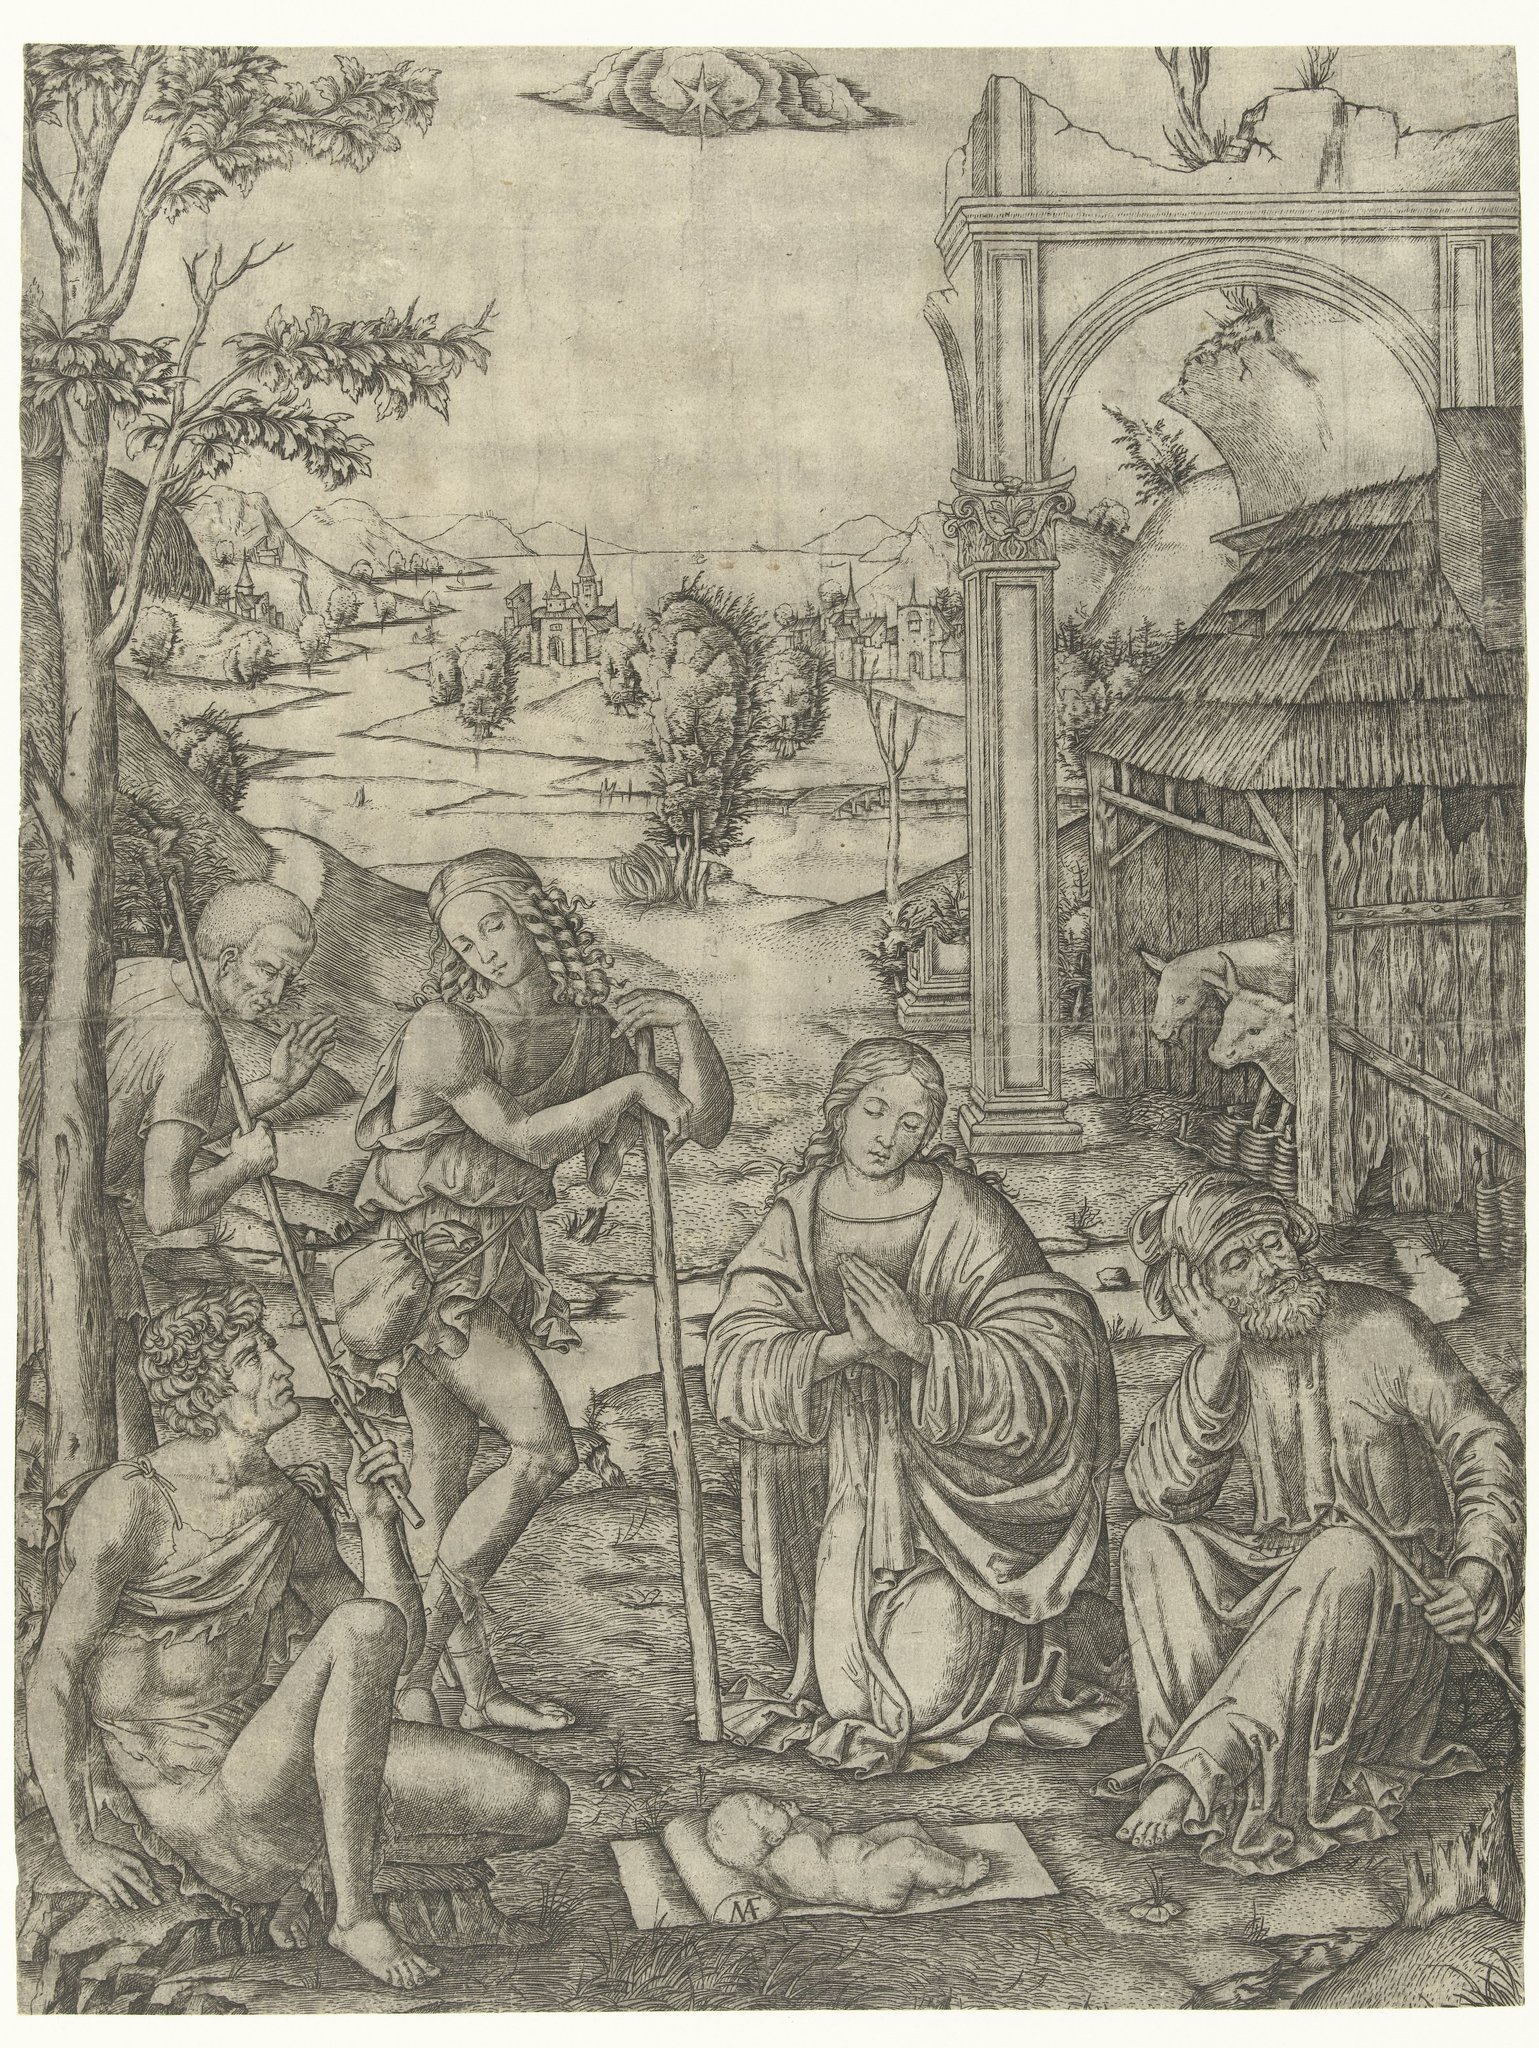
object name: print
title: Aanbidding van het Christuskind door Maria en Jozef en de herders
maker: marcantonio raimondi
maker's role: print maker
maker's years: 1470-1534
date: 1502-1506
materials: paper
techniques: engraving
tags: adoration of the christ-child by the shepherds; mary and joseph present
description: Voor deze prent ontleende Marcantonio Raimondi verschillende motieven aan het werk van Francesco di Francia (Shoemaker 1981, p. 52). Op het opzetkarton staat een notitie over de verdwenen doublure waarop zich verzamelaarsmerken bevonden (waarschijnlijk Lugt 10 en 11).